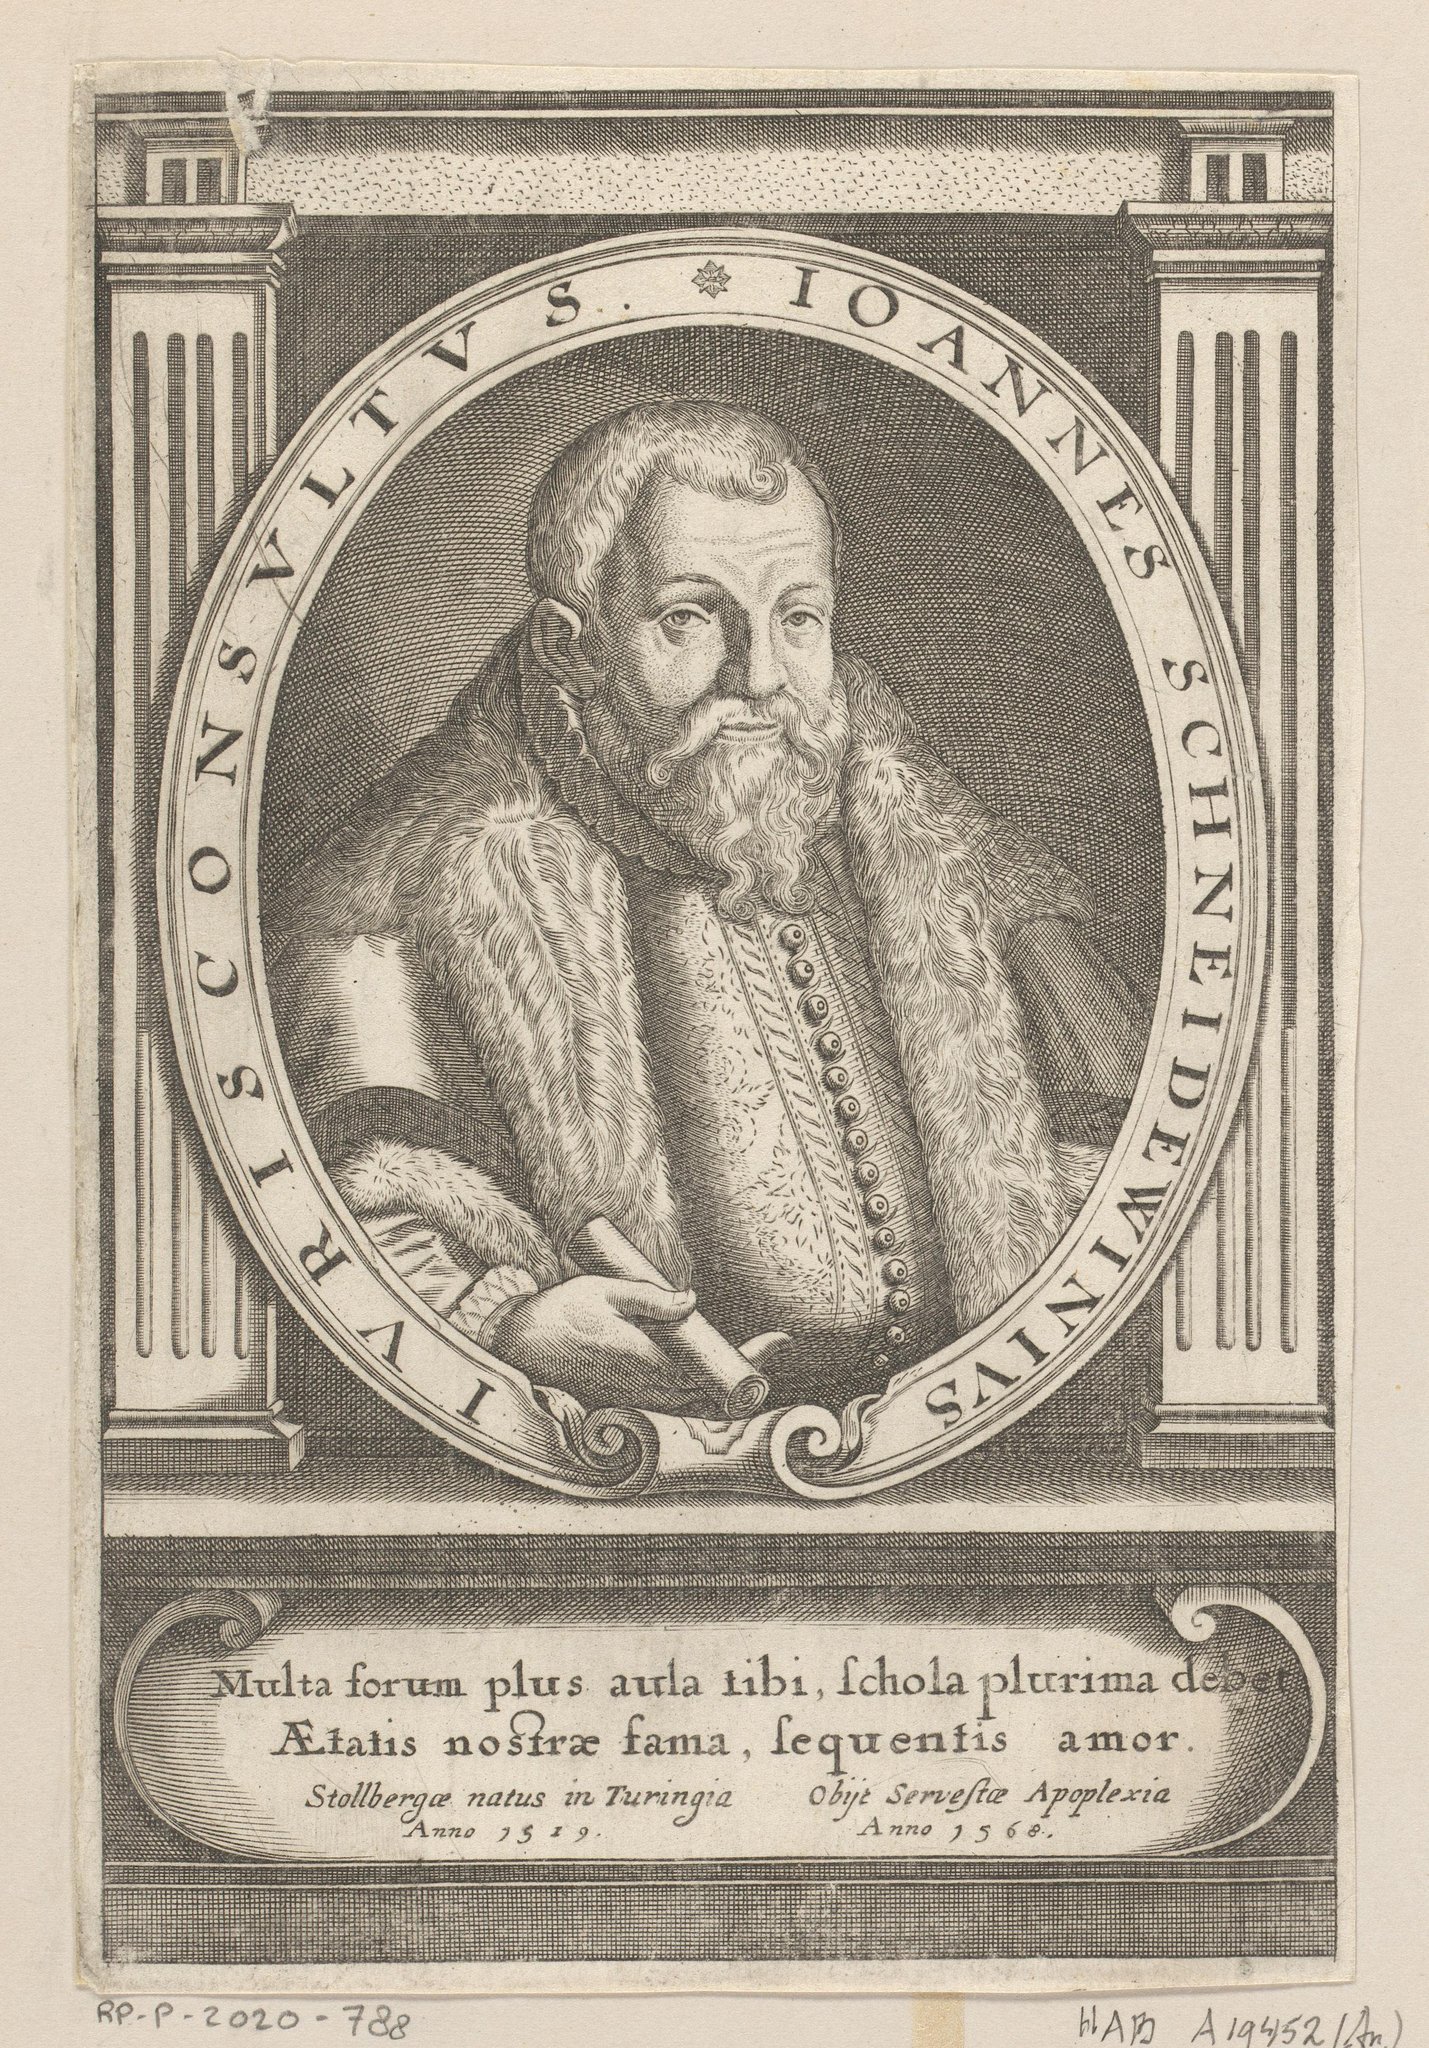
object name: print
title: Joannes Schneidewinius jurisconsultus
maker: Anonymous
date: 1650-1699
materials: paper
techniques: engraving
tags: historical persons